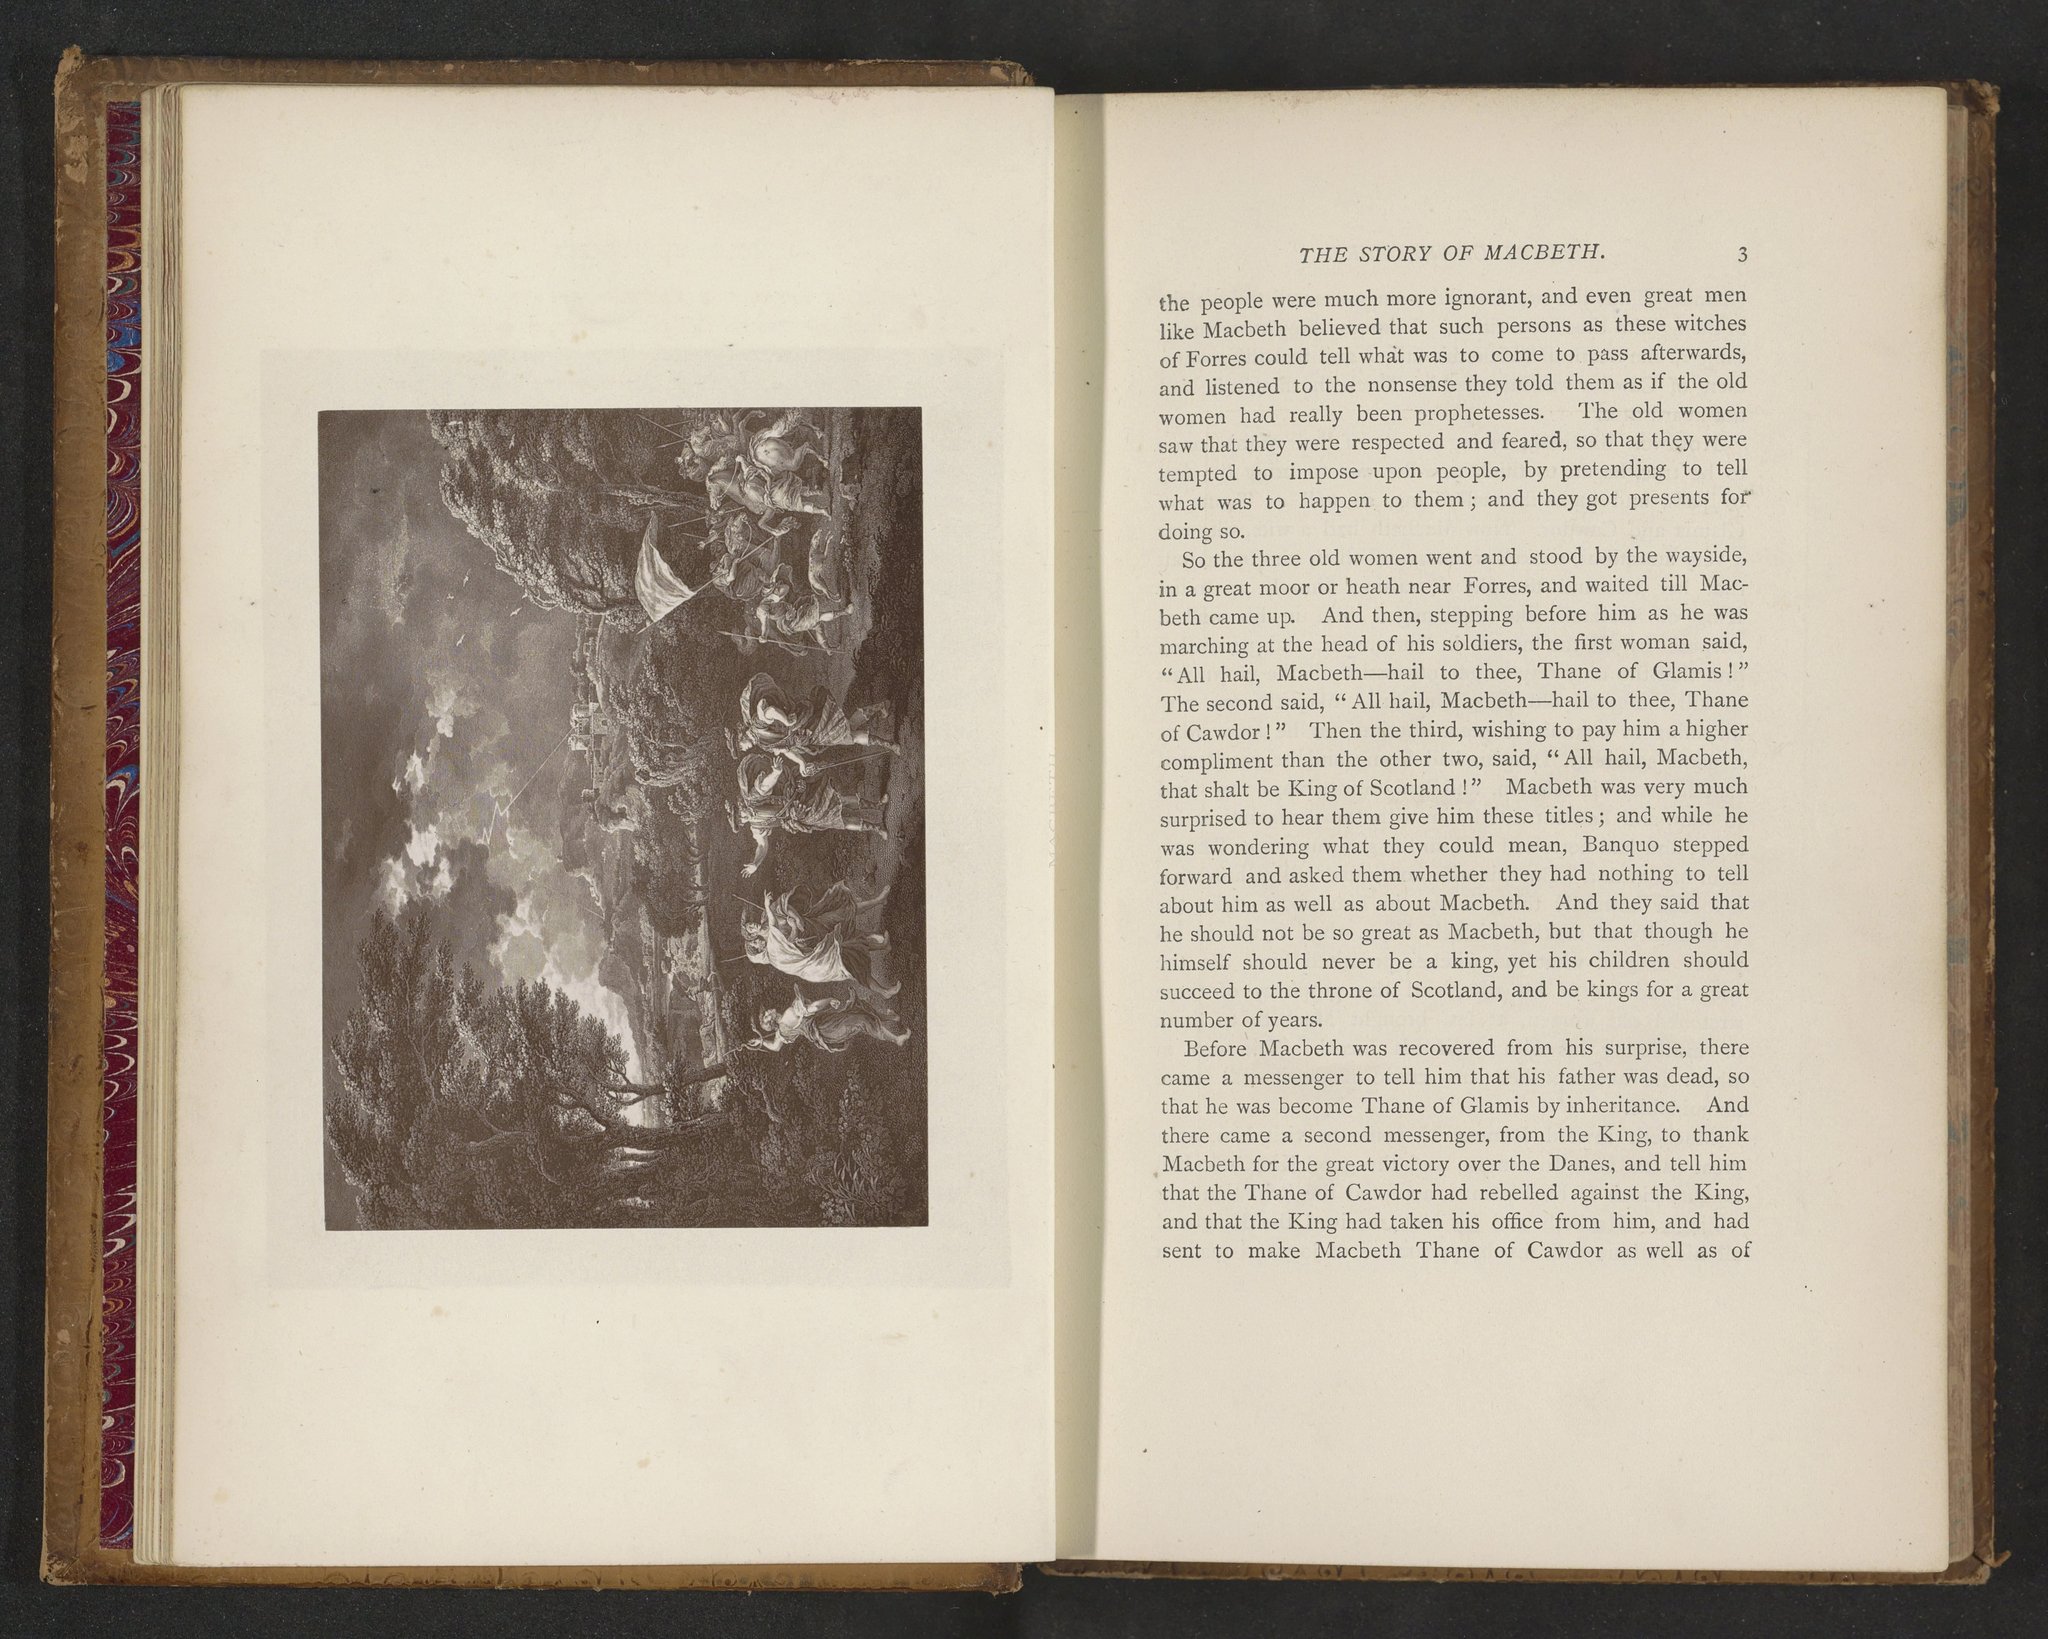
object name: page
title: Macbeth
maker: Anonymous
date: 1874-1884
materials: paper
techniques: woodburytype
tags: witch, sorceress, macbeth